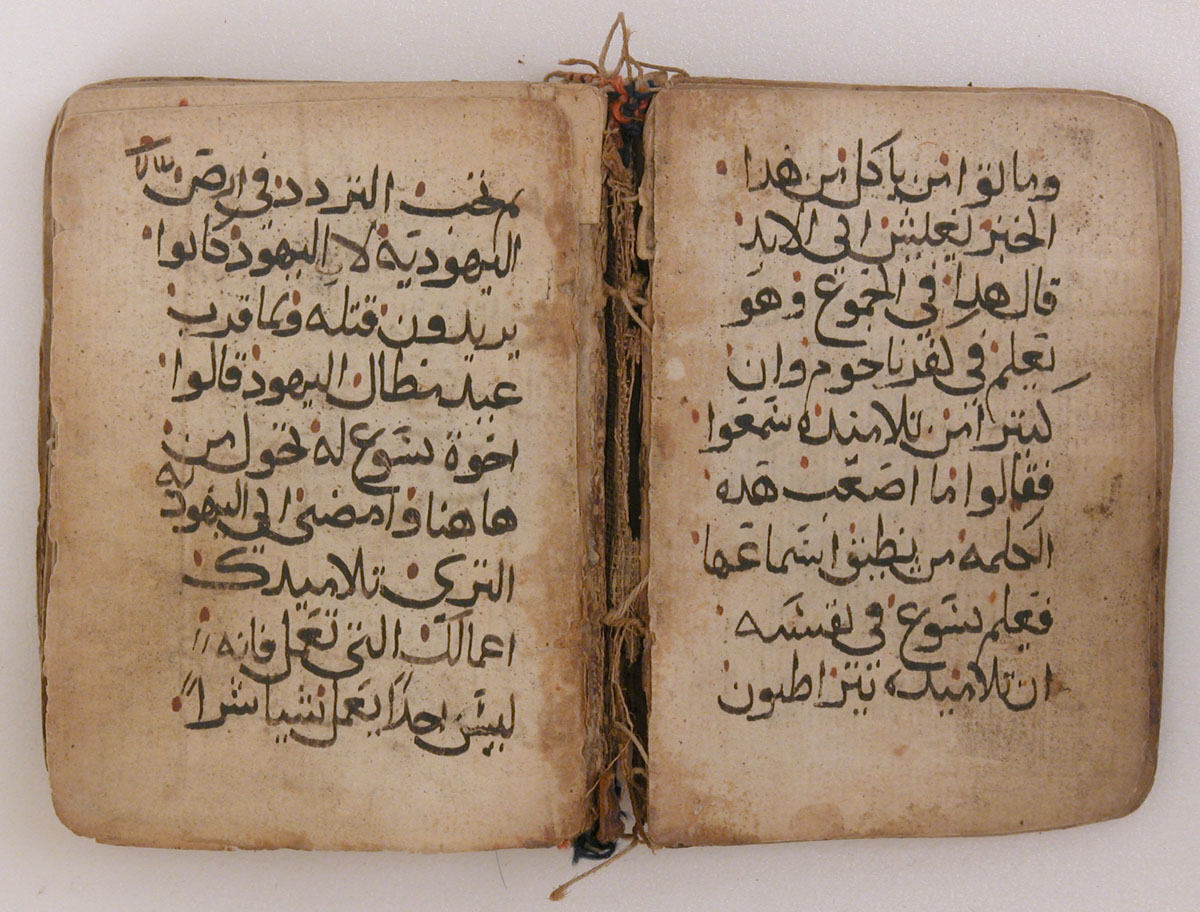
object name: non illustrated manuscript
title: Manuscript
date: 1001-1200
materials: ink, paper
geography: egypt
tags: arabic,calligraphy